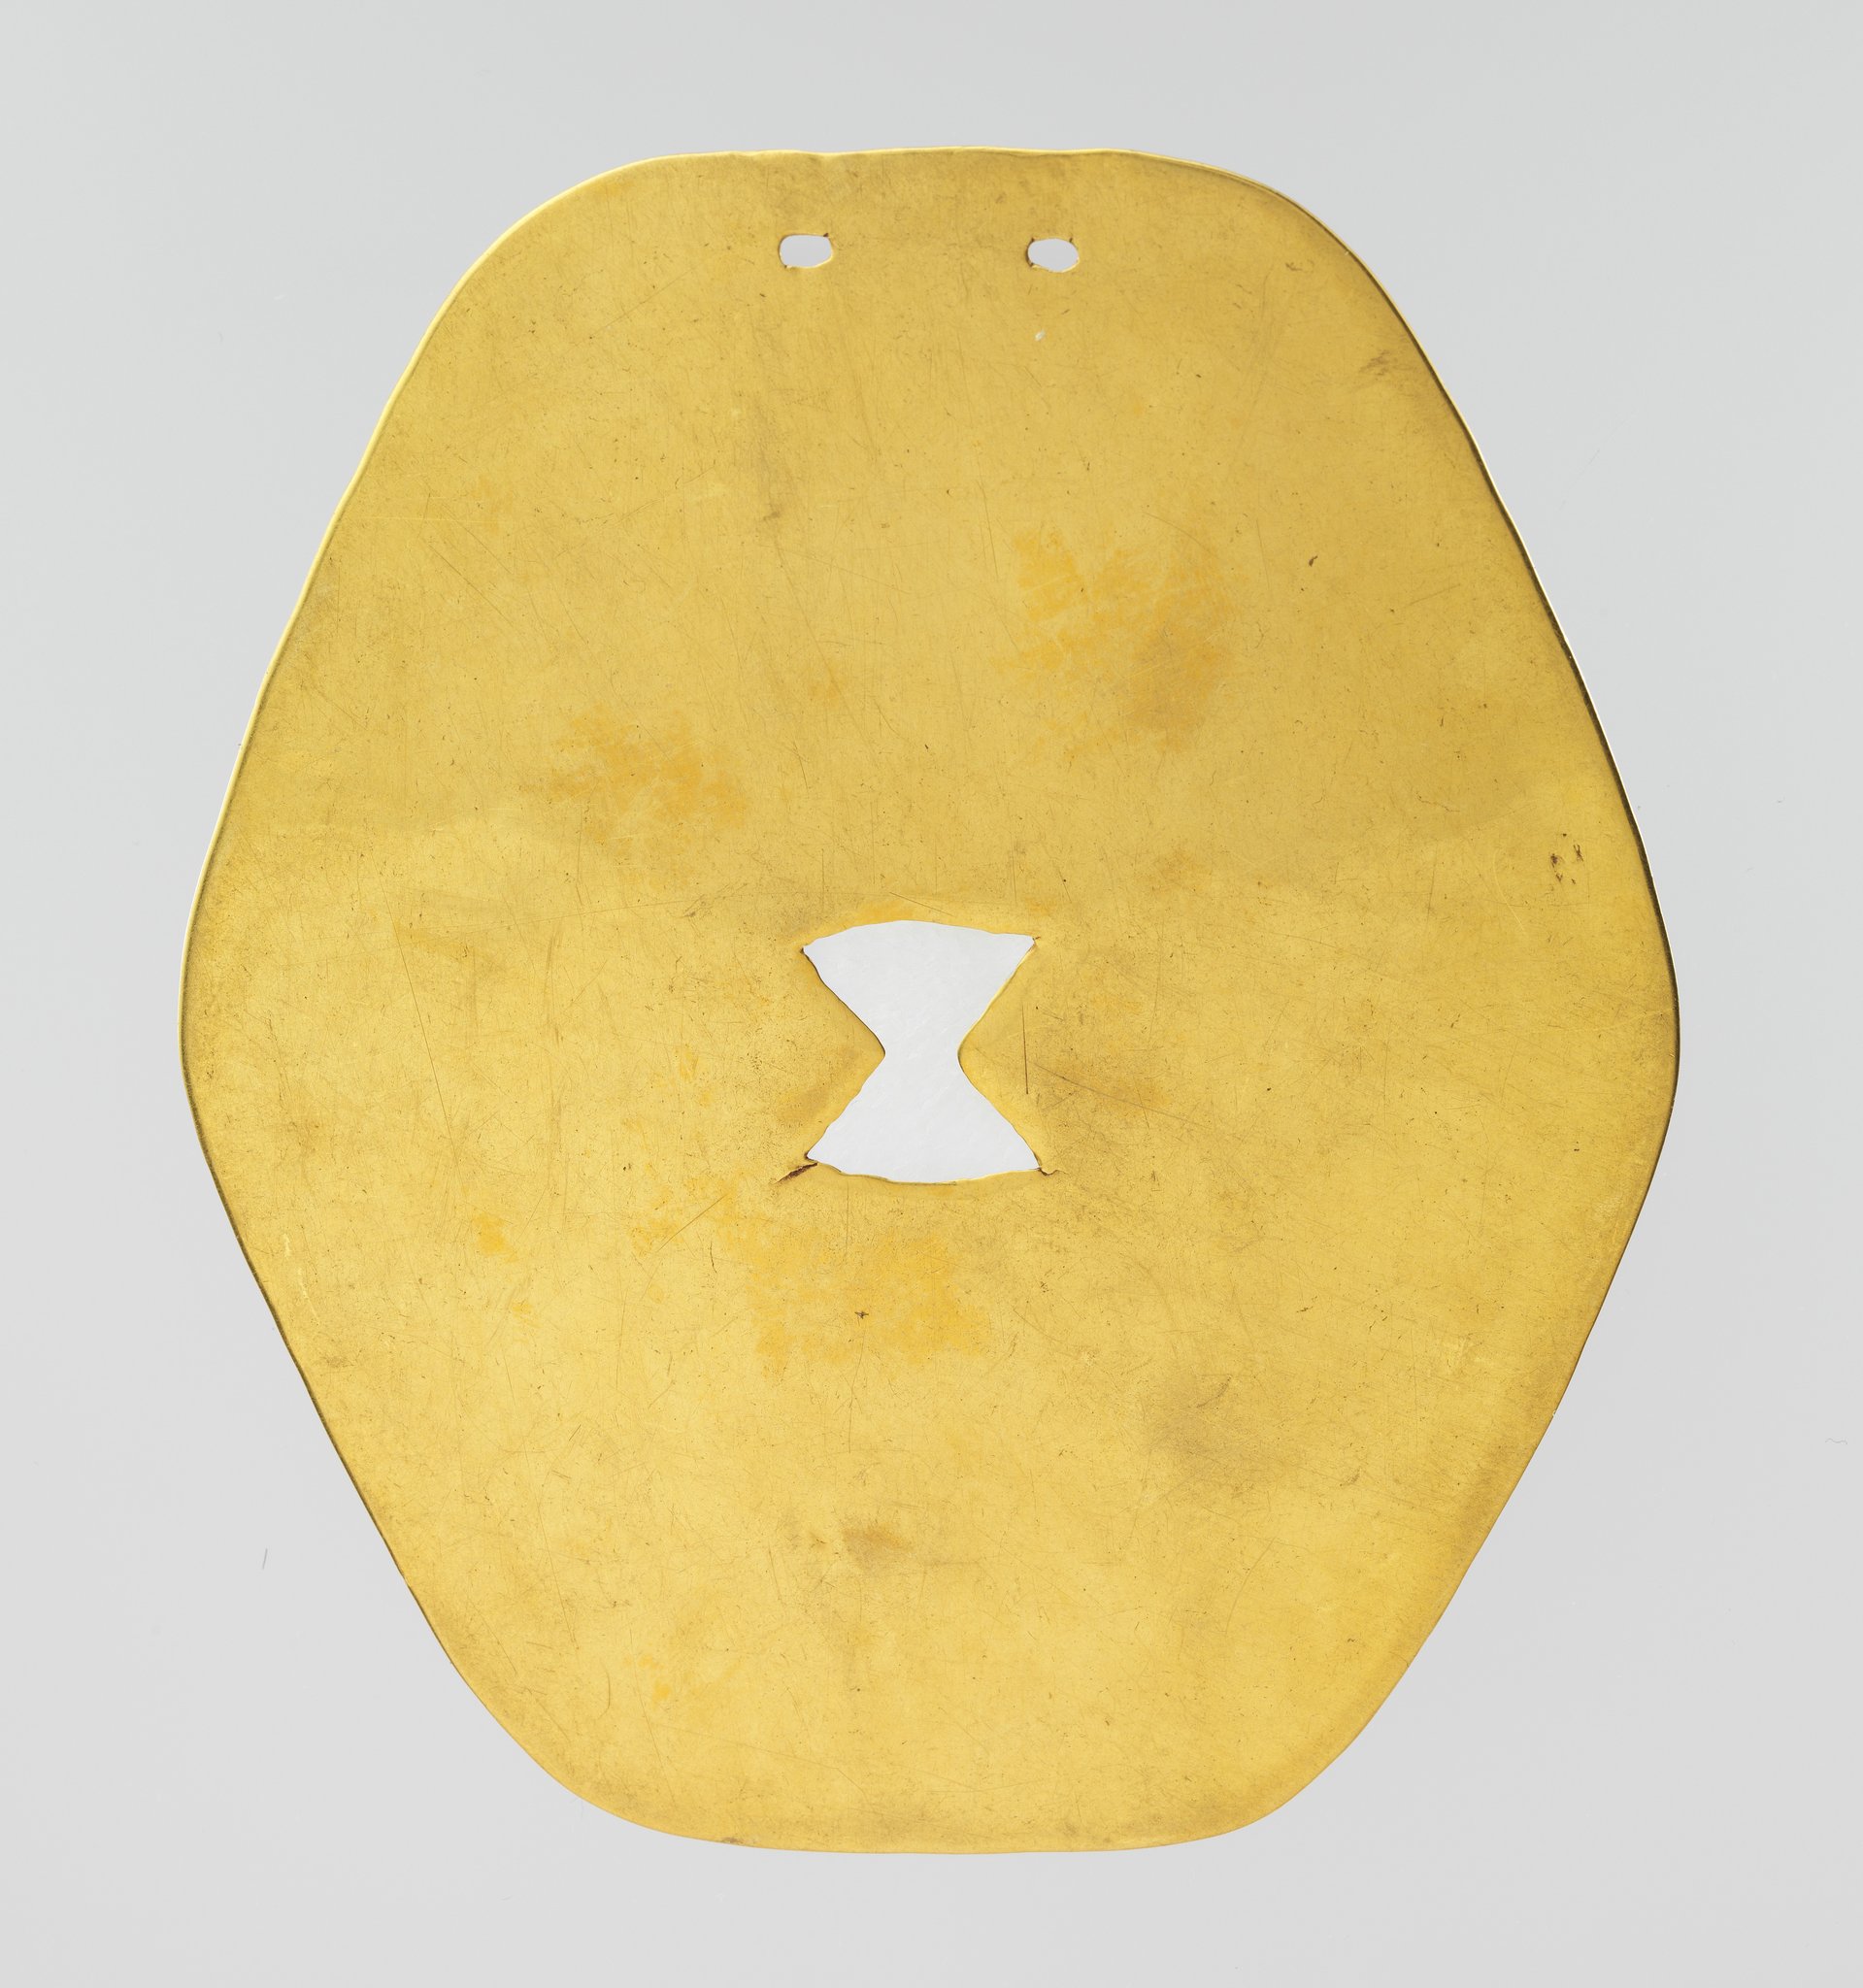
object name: plaque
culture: condorhuasi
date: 500 BCE-450 CE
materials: gold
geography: argentina